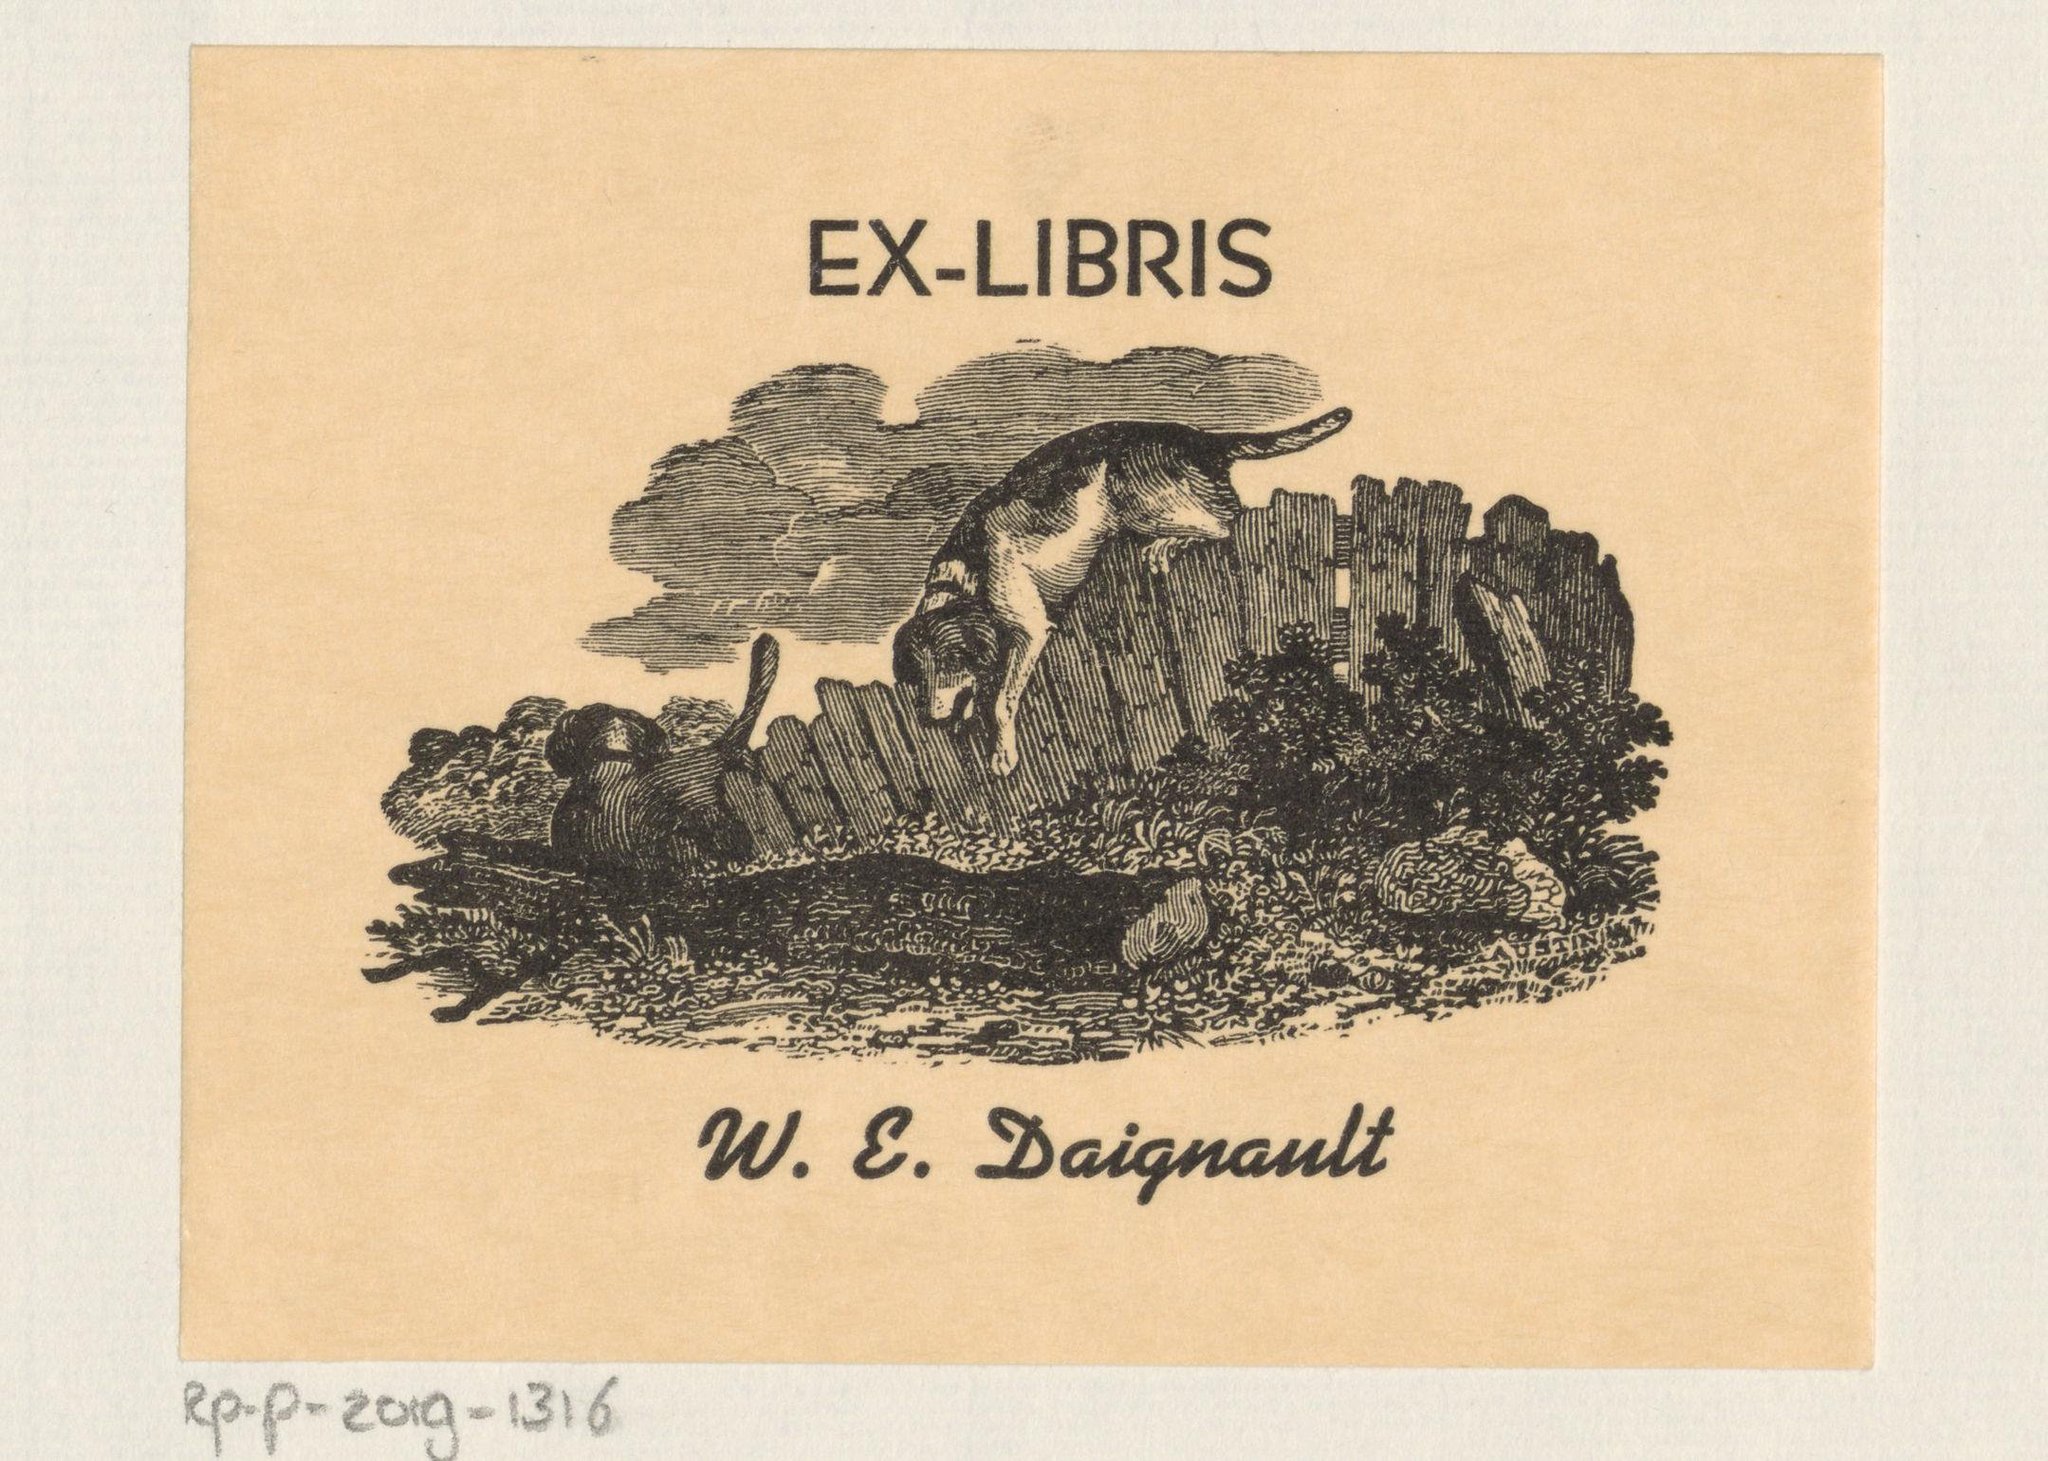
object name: bookplate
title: Ex libris van W.E. Daignault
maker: austin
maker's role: print maker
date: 1800-1899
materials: paper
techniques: engraving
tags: dog